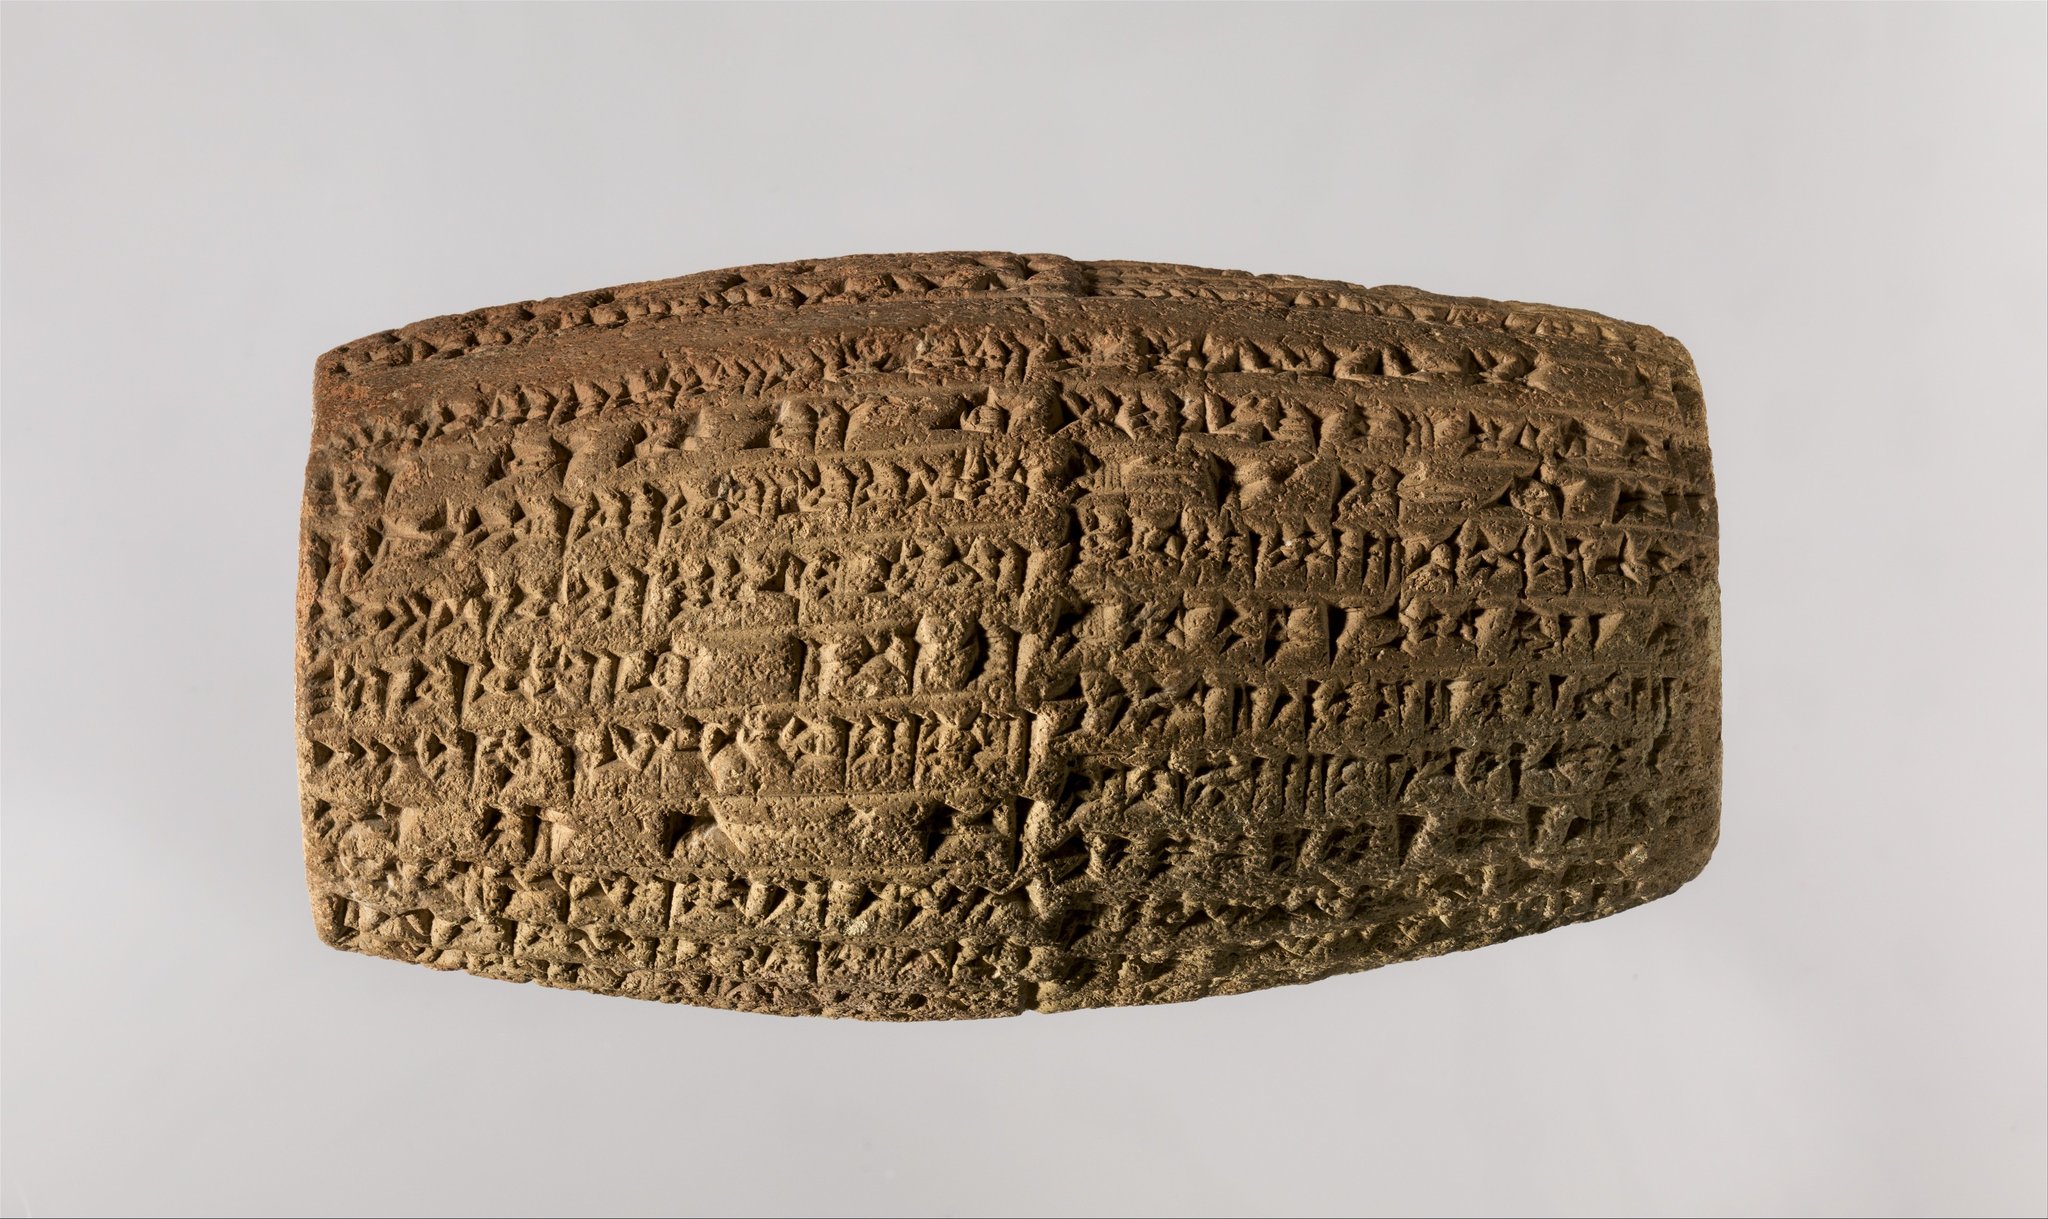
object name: cuneiform cylinder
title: Cuneiform cylinder: inscription of Nebuchadnezzar II describing the construction of the outer city wall of Babylon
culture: babylonian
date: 604-562 BCE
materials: clay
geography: mesopotamia